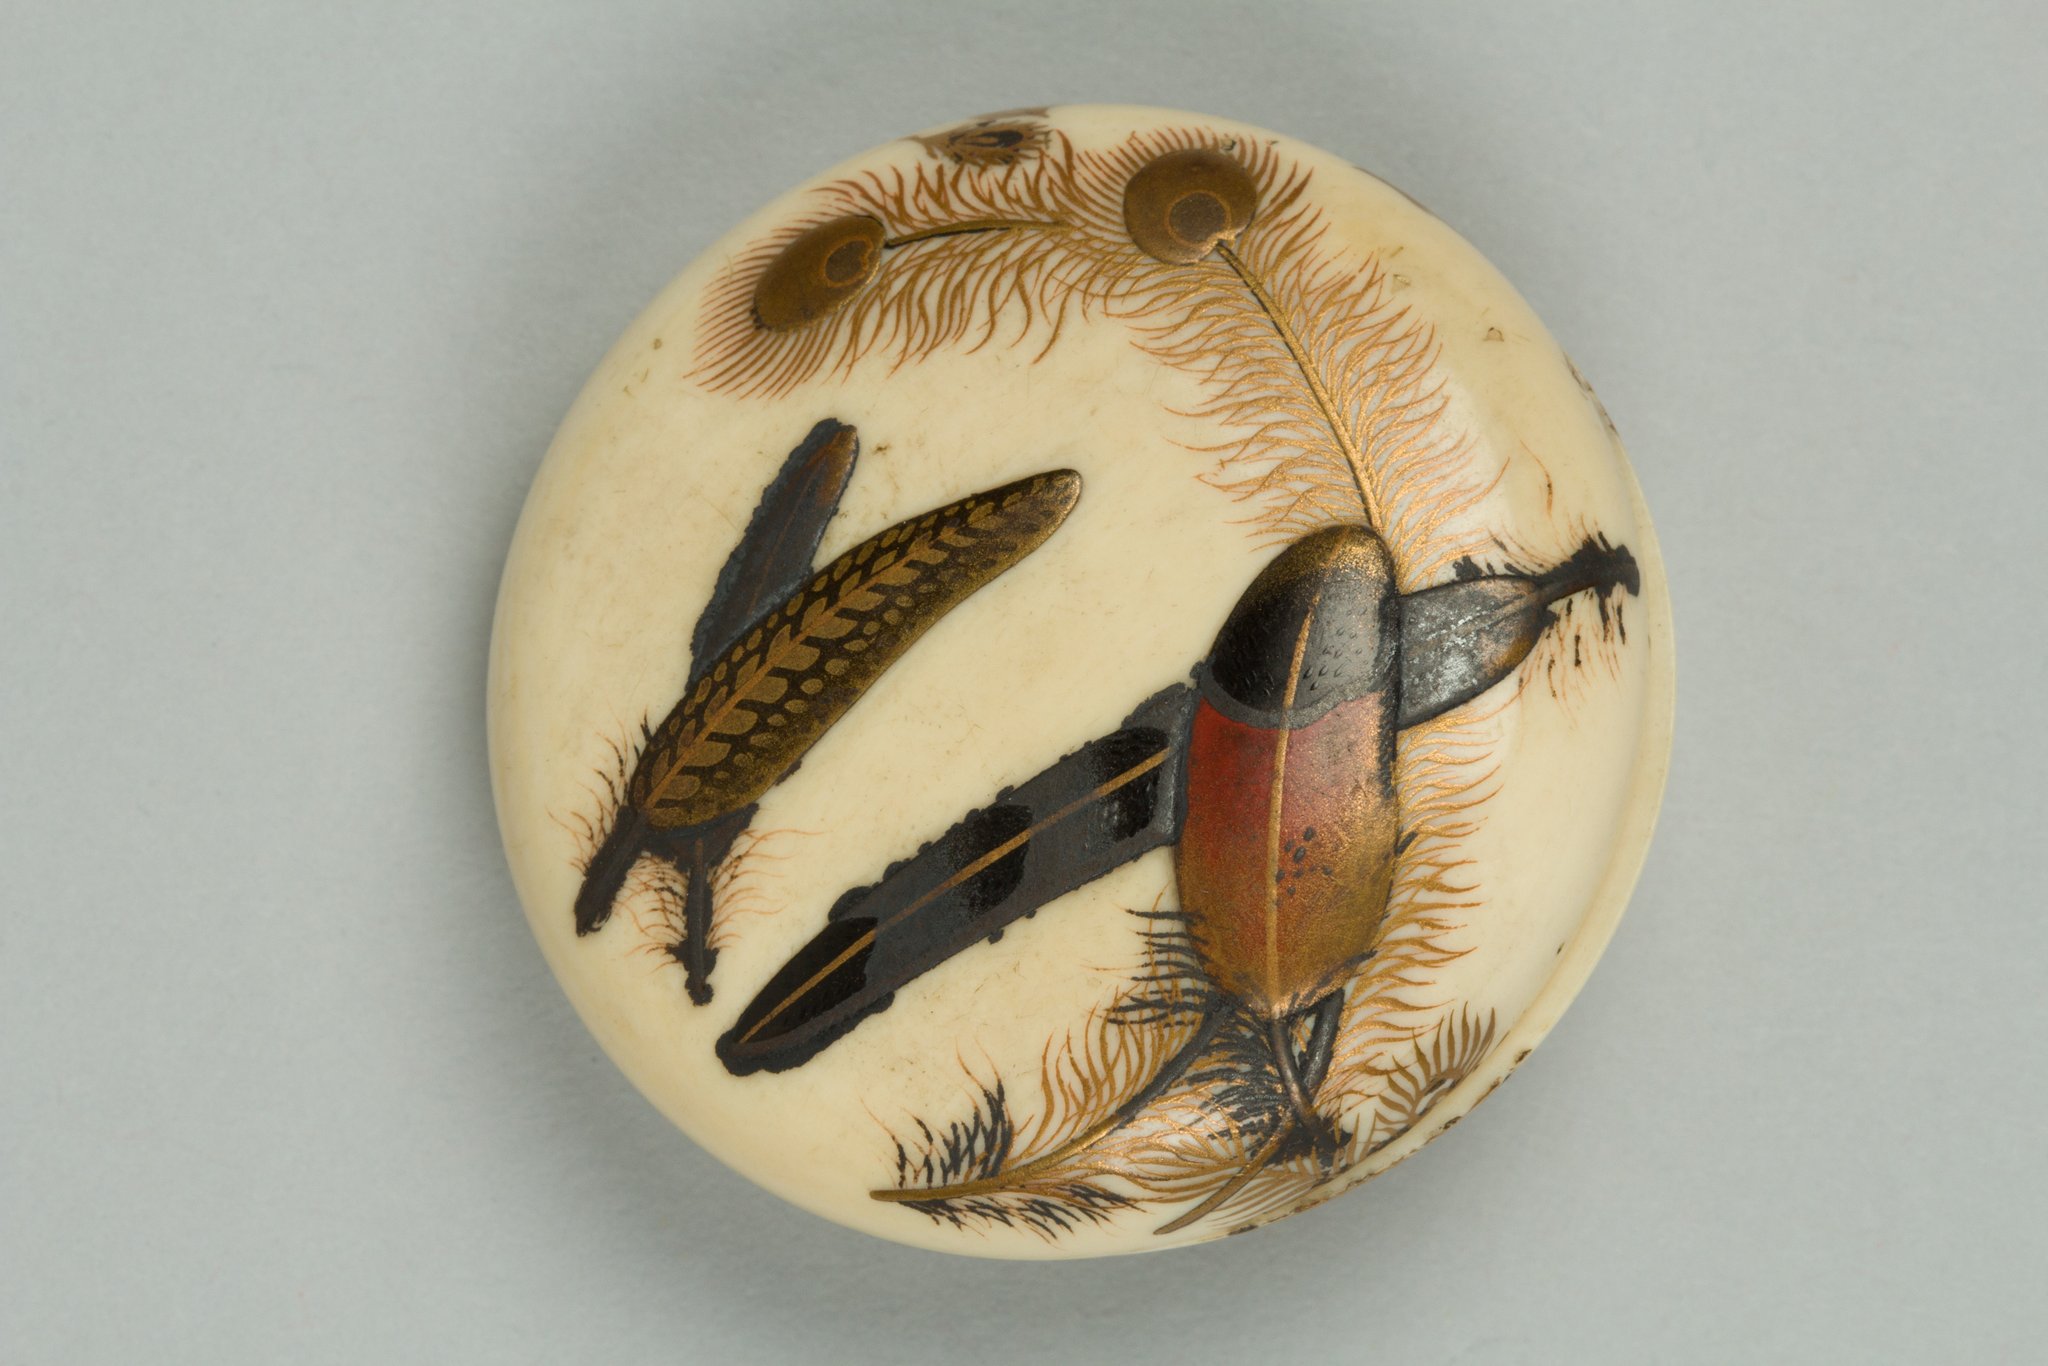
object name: netsuke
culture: japanese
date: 1801-1900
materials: ivory, lacquer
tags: feathers